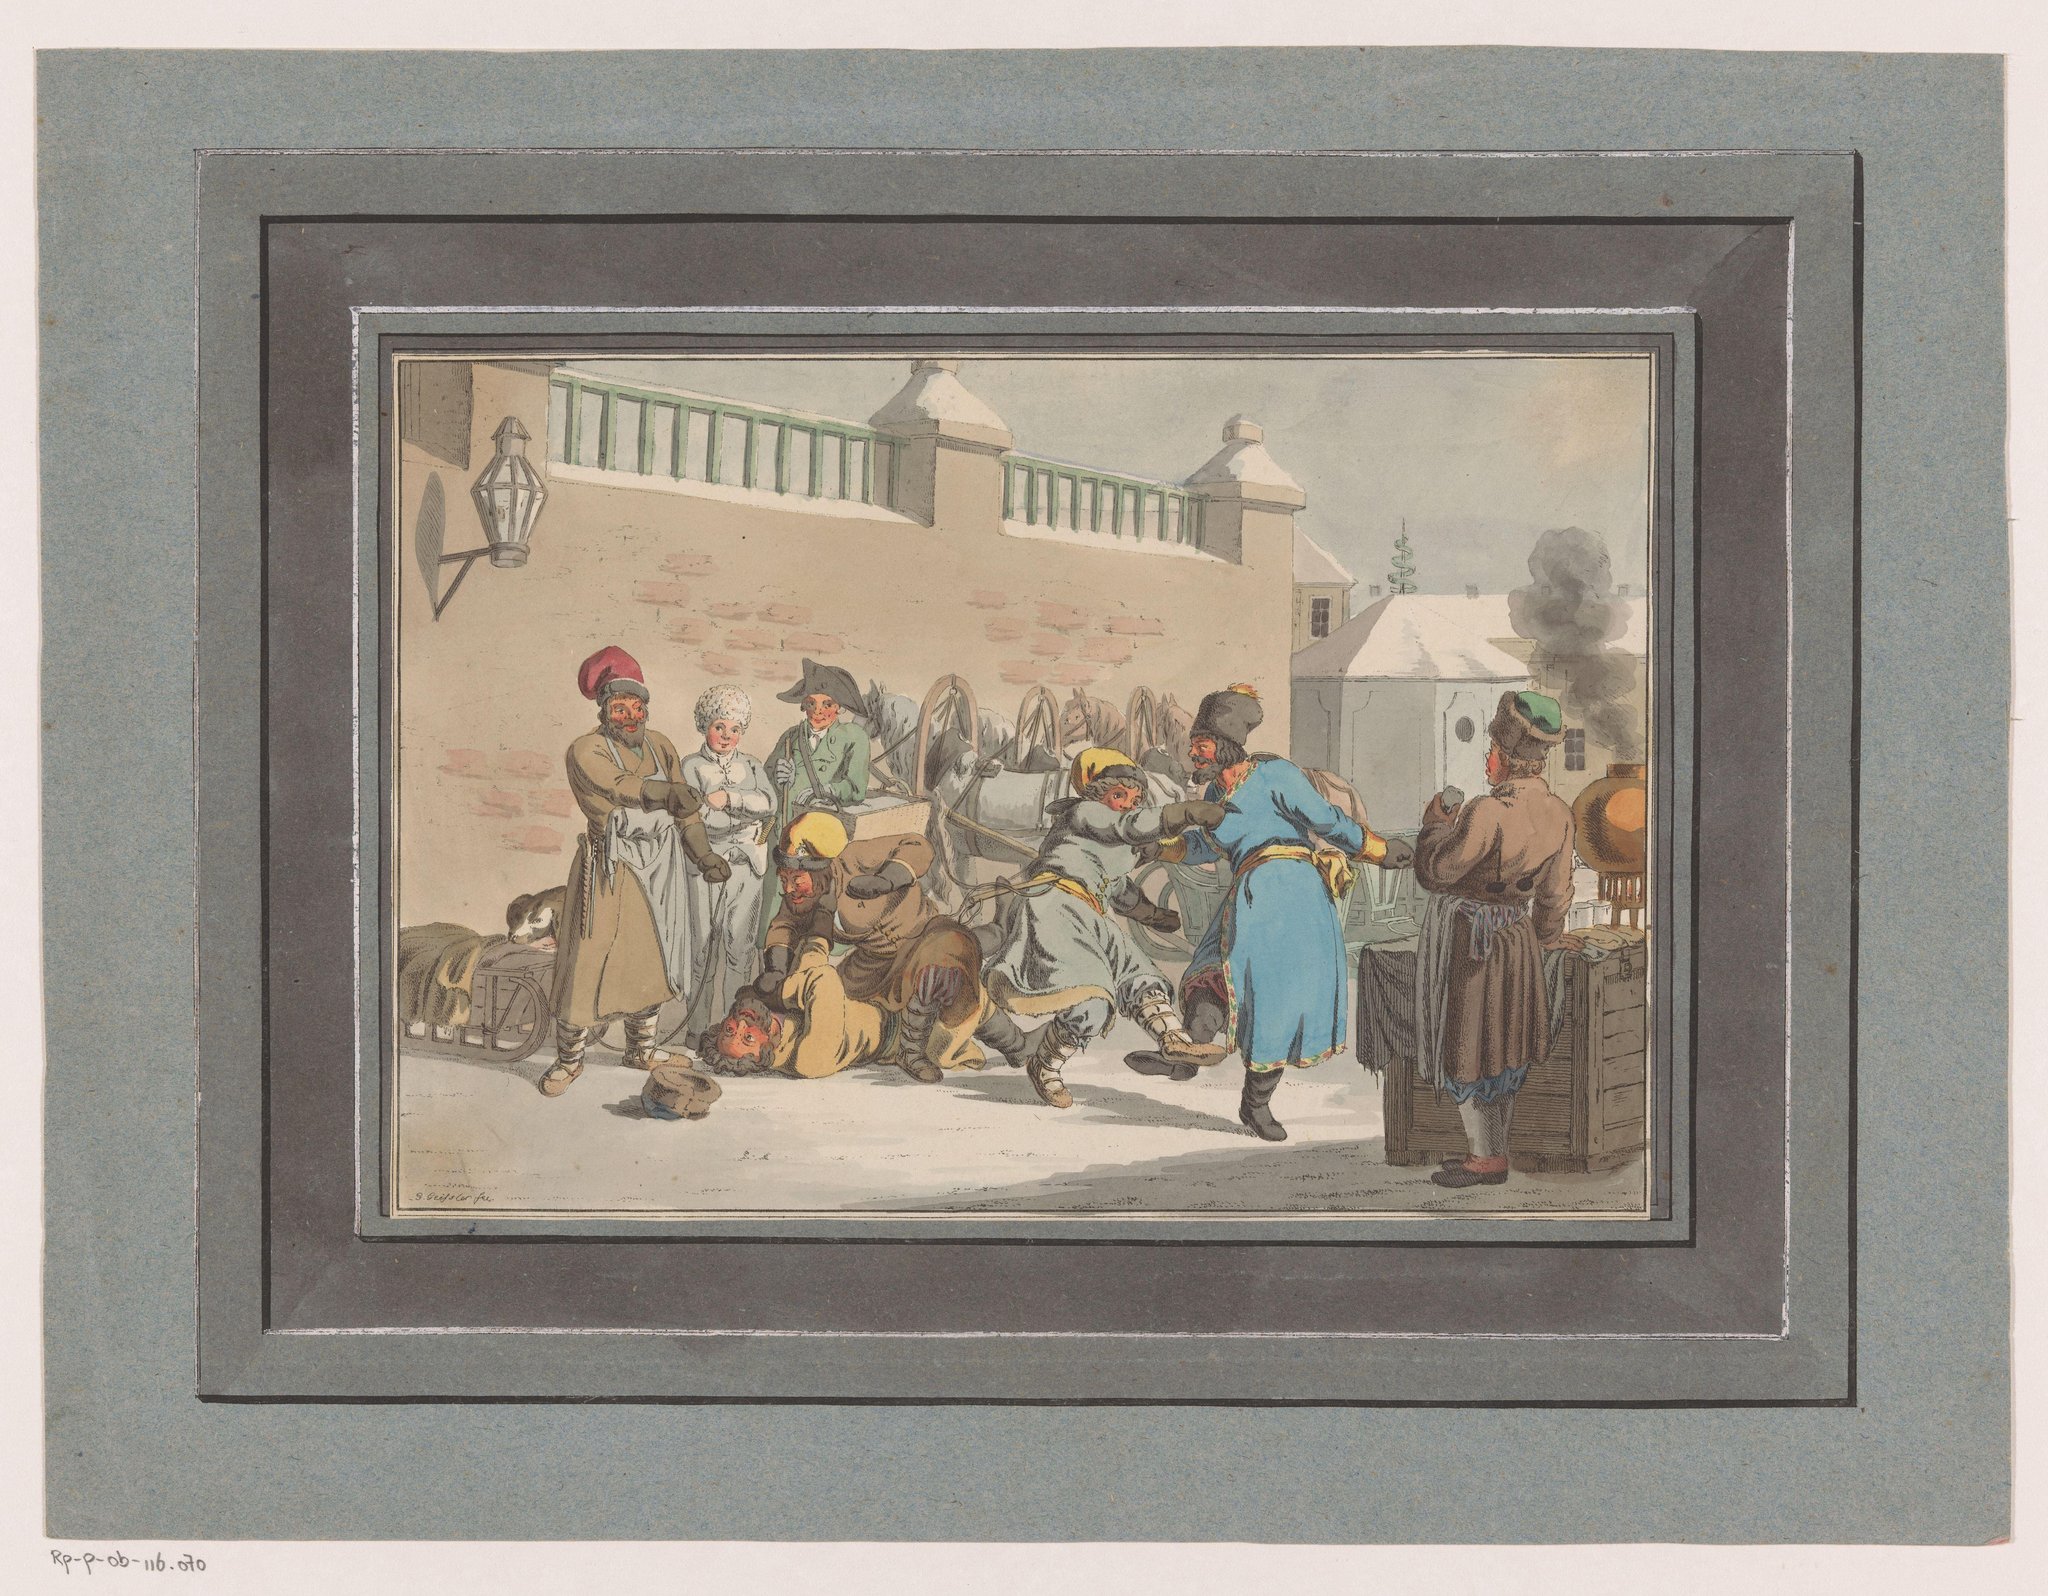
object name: print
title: Russisch volksvermaak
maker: christian gottfried heinrich geissler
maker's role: print maker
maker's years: 1770-1844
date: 1805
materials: paper, watercolor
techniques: etching, hand coloring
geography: leipzig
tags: snow, horse, europeans (with name), fighting, russia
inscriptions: collector's mark: Lugt 2228